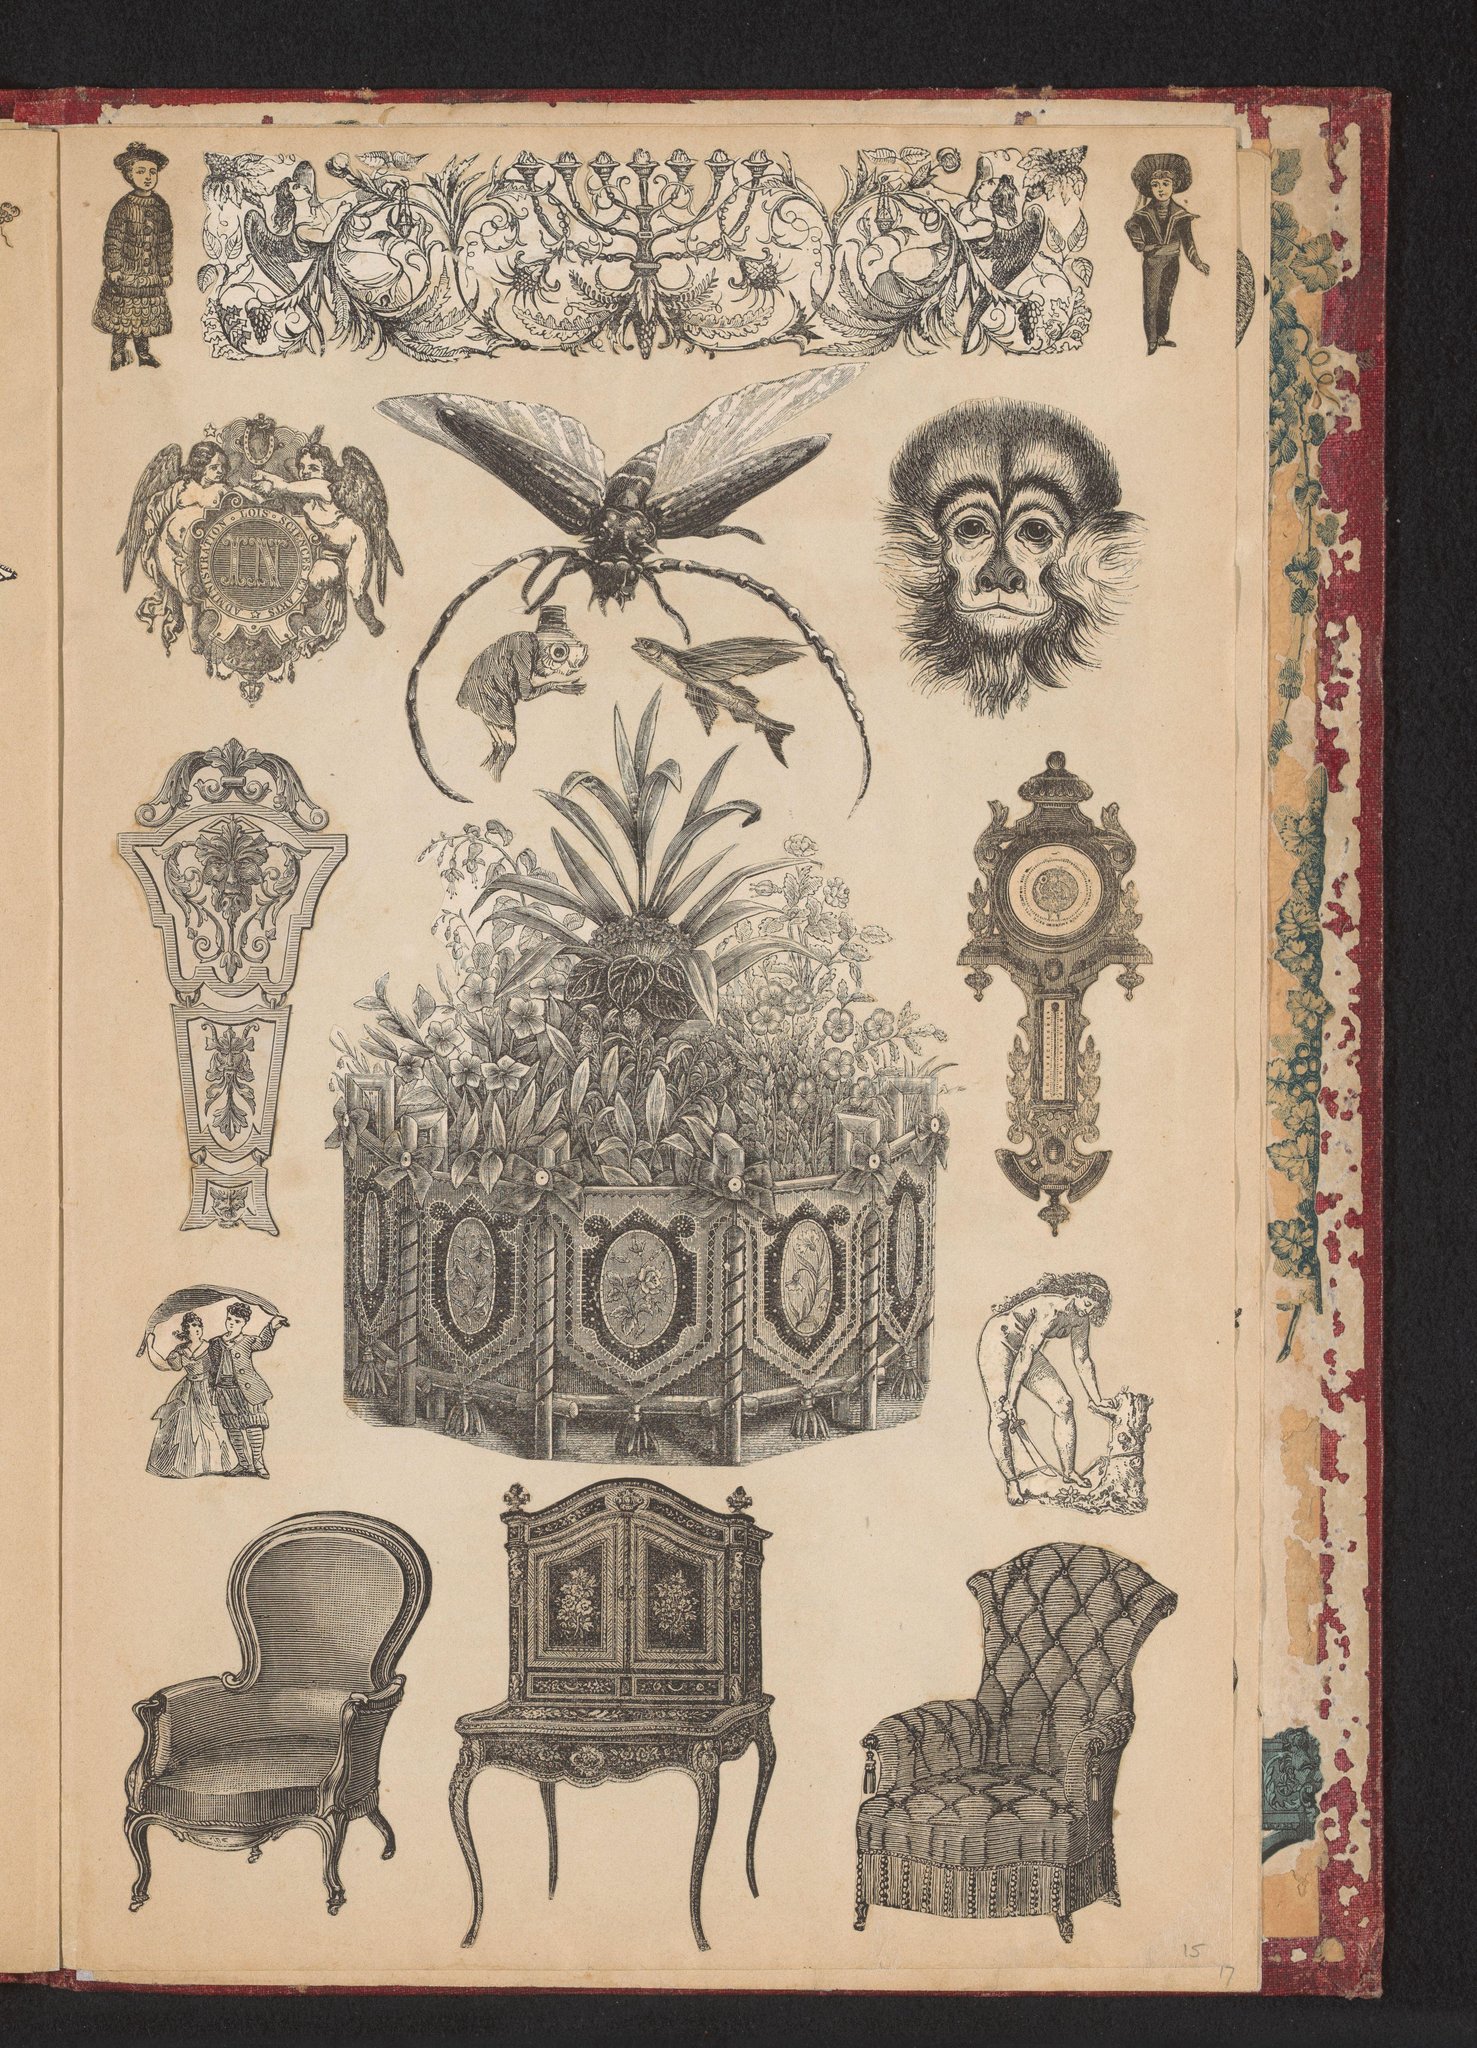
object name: print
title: Collage van uitgeknipte prenten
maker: Anonymous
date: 1870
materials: paper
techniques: engraving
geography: paris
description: Collage van uitgeknipte prenten. Onderdeel van een album met 18 bladen, aan beide zijden beplakt met uitgeknipte prenten, vermoedelijk afkomstig uit 19e-eeuwse tijdschiften.